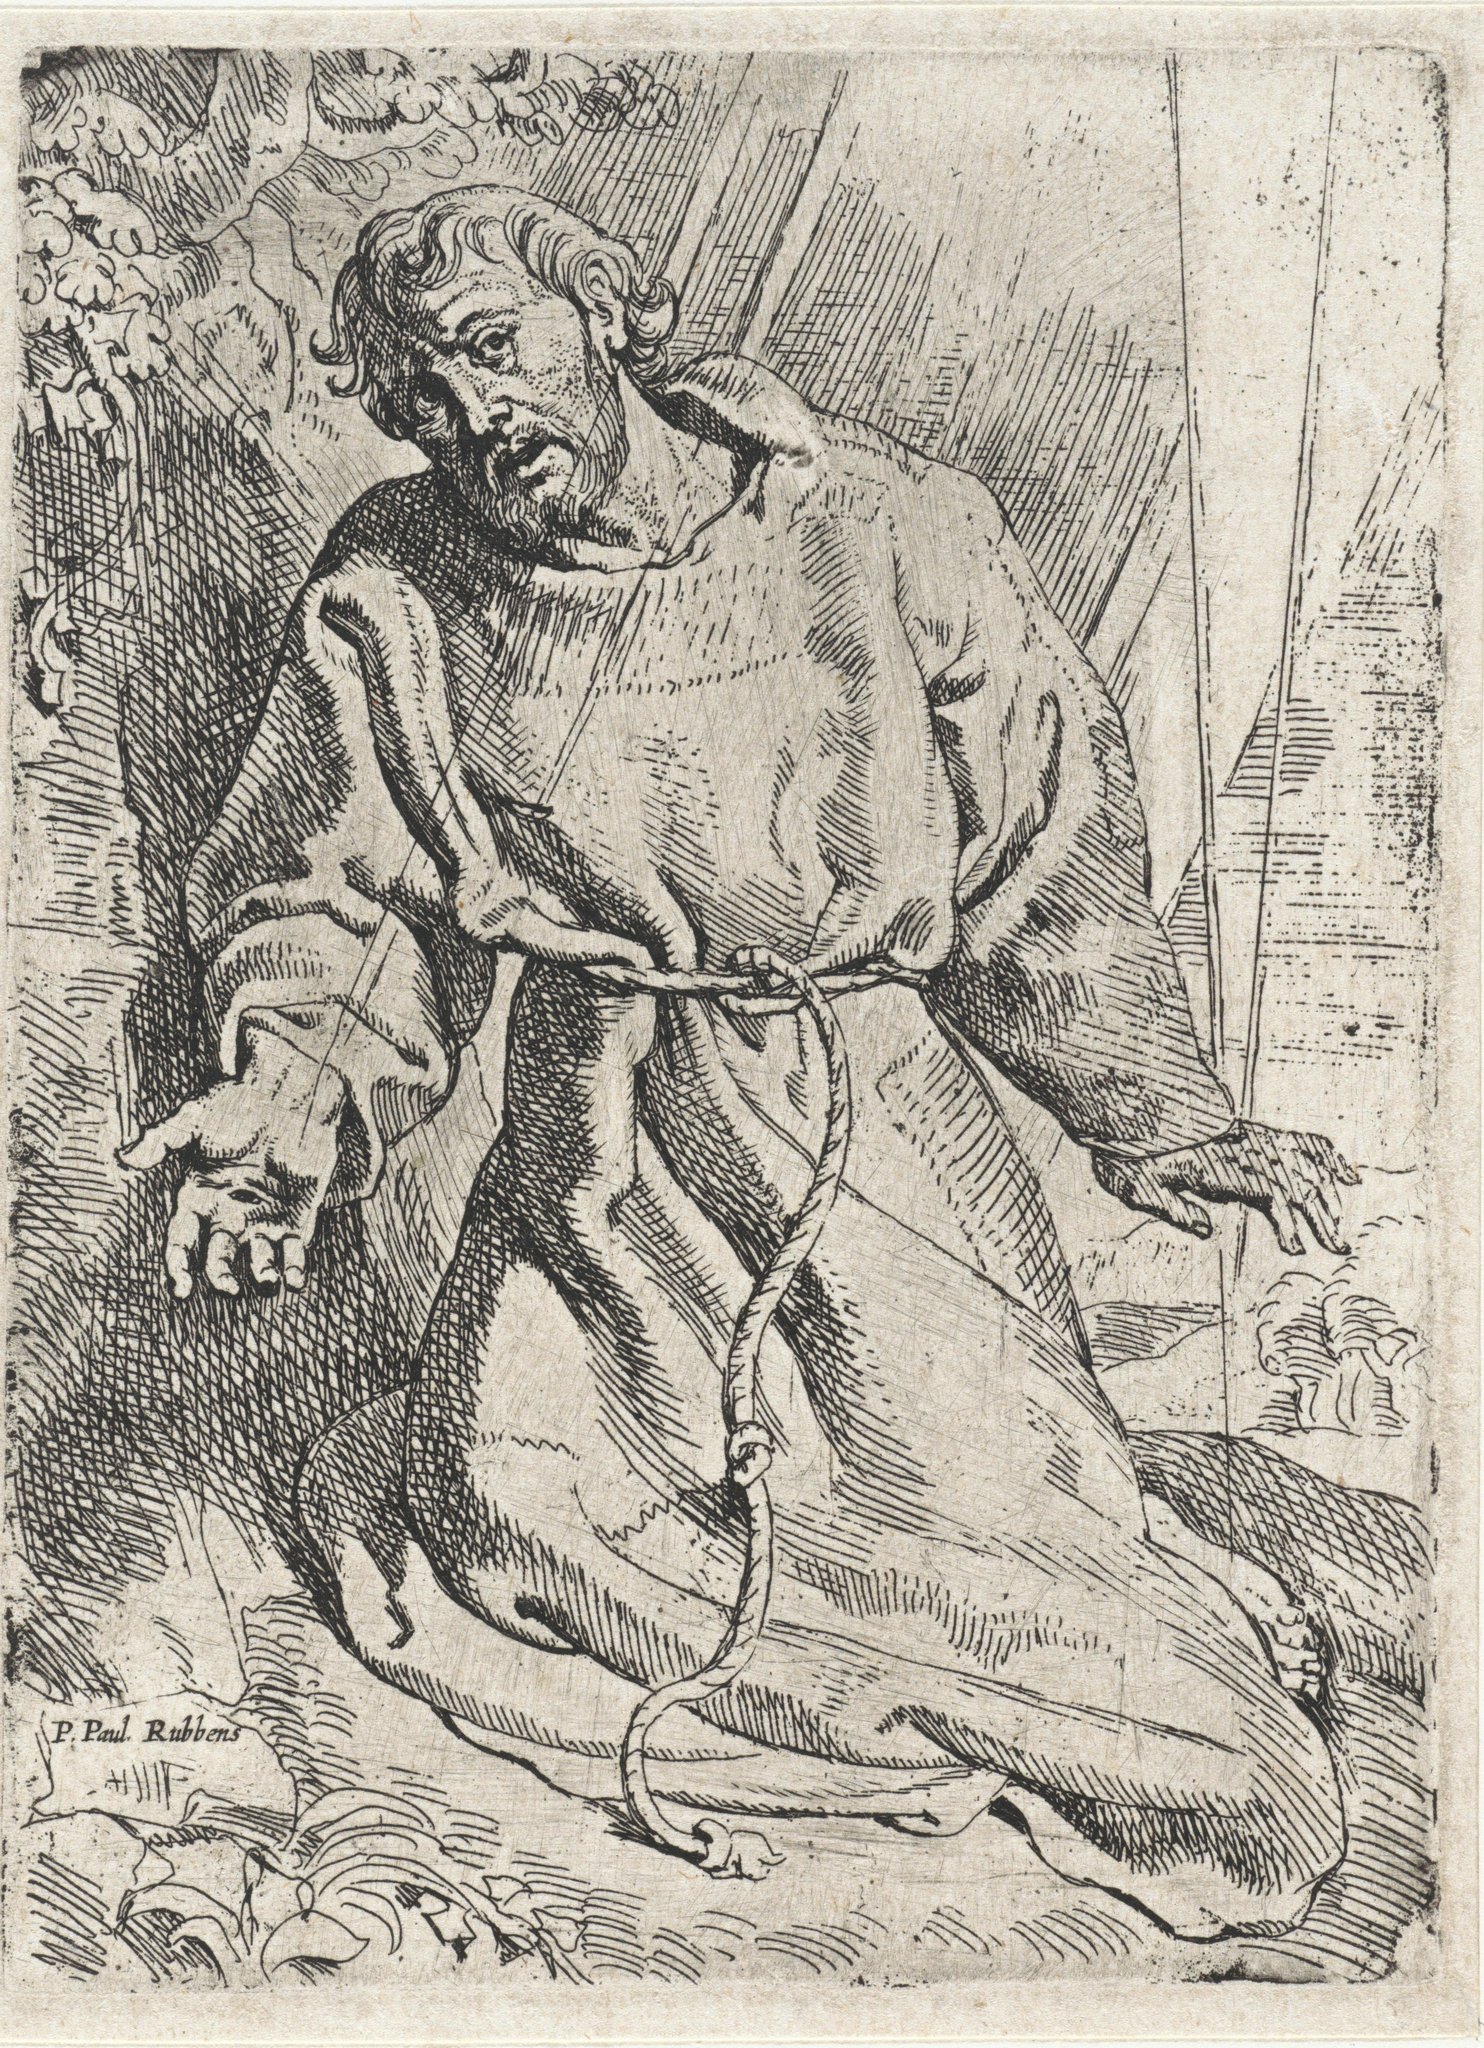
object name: print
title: H. Franciscus van Assisi ontvangt de stigmata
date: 1598-1690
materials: paper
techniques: etching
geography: antwerp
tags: st. francis of assisi in ecstasy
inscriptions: collector's mark: Lugt 240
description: De heilige Franciscus van Assisi knielt op een berg, waar hij de stigmata ontvangt.